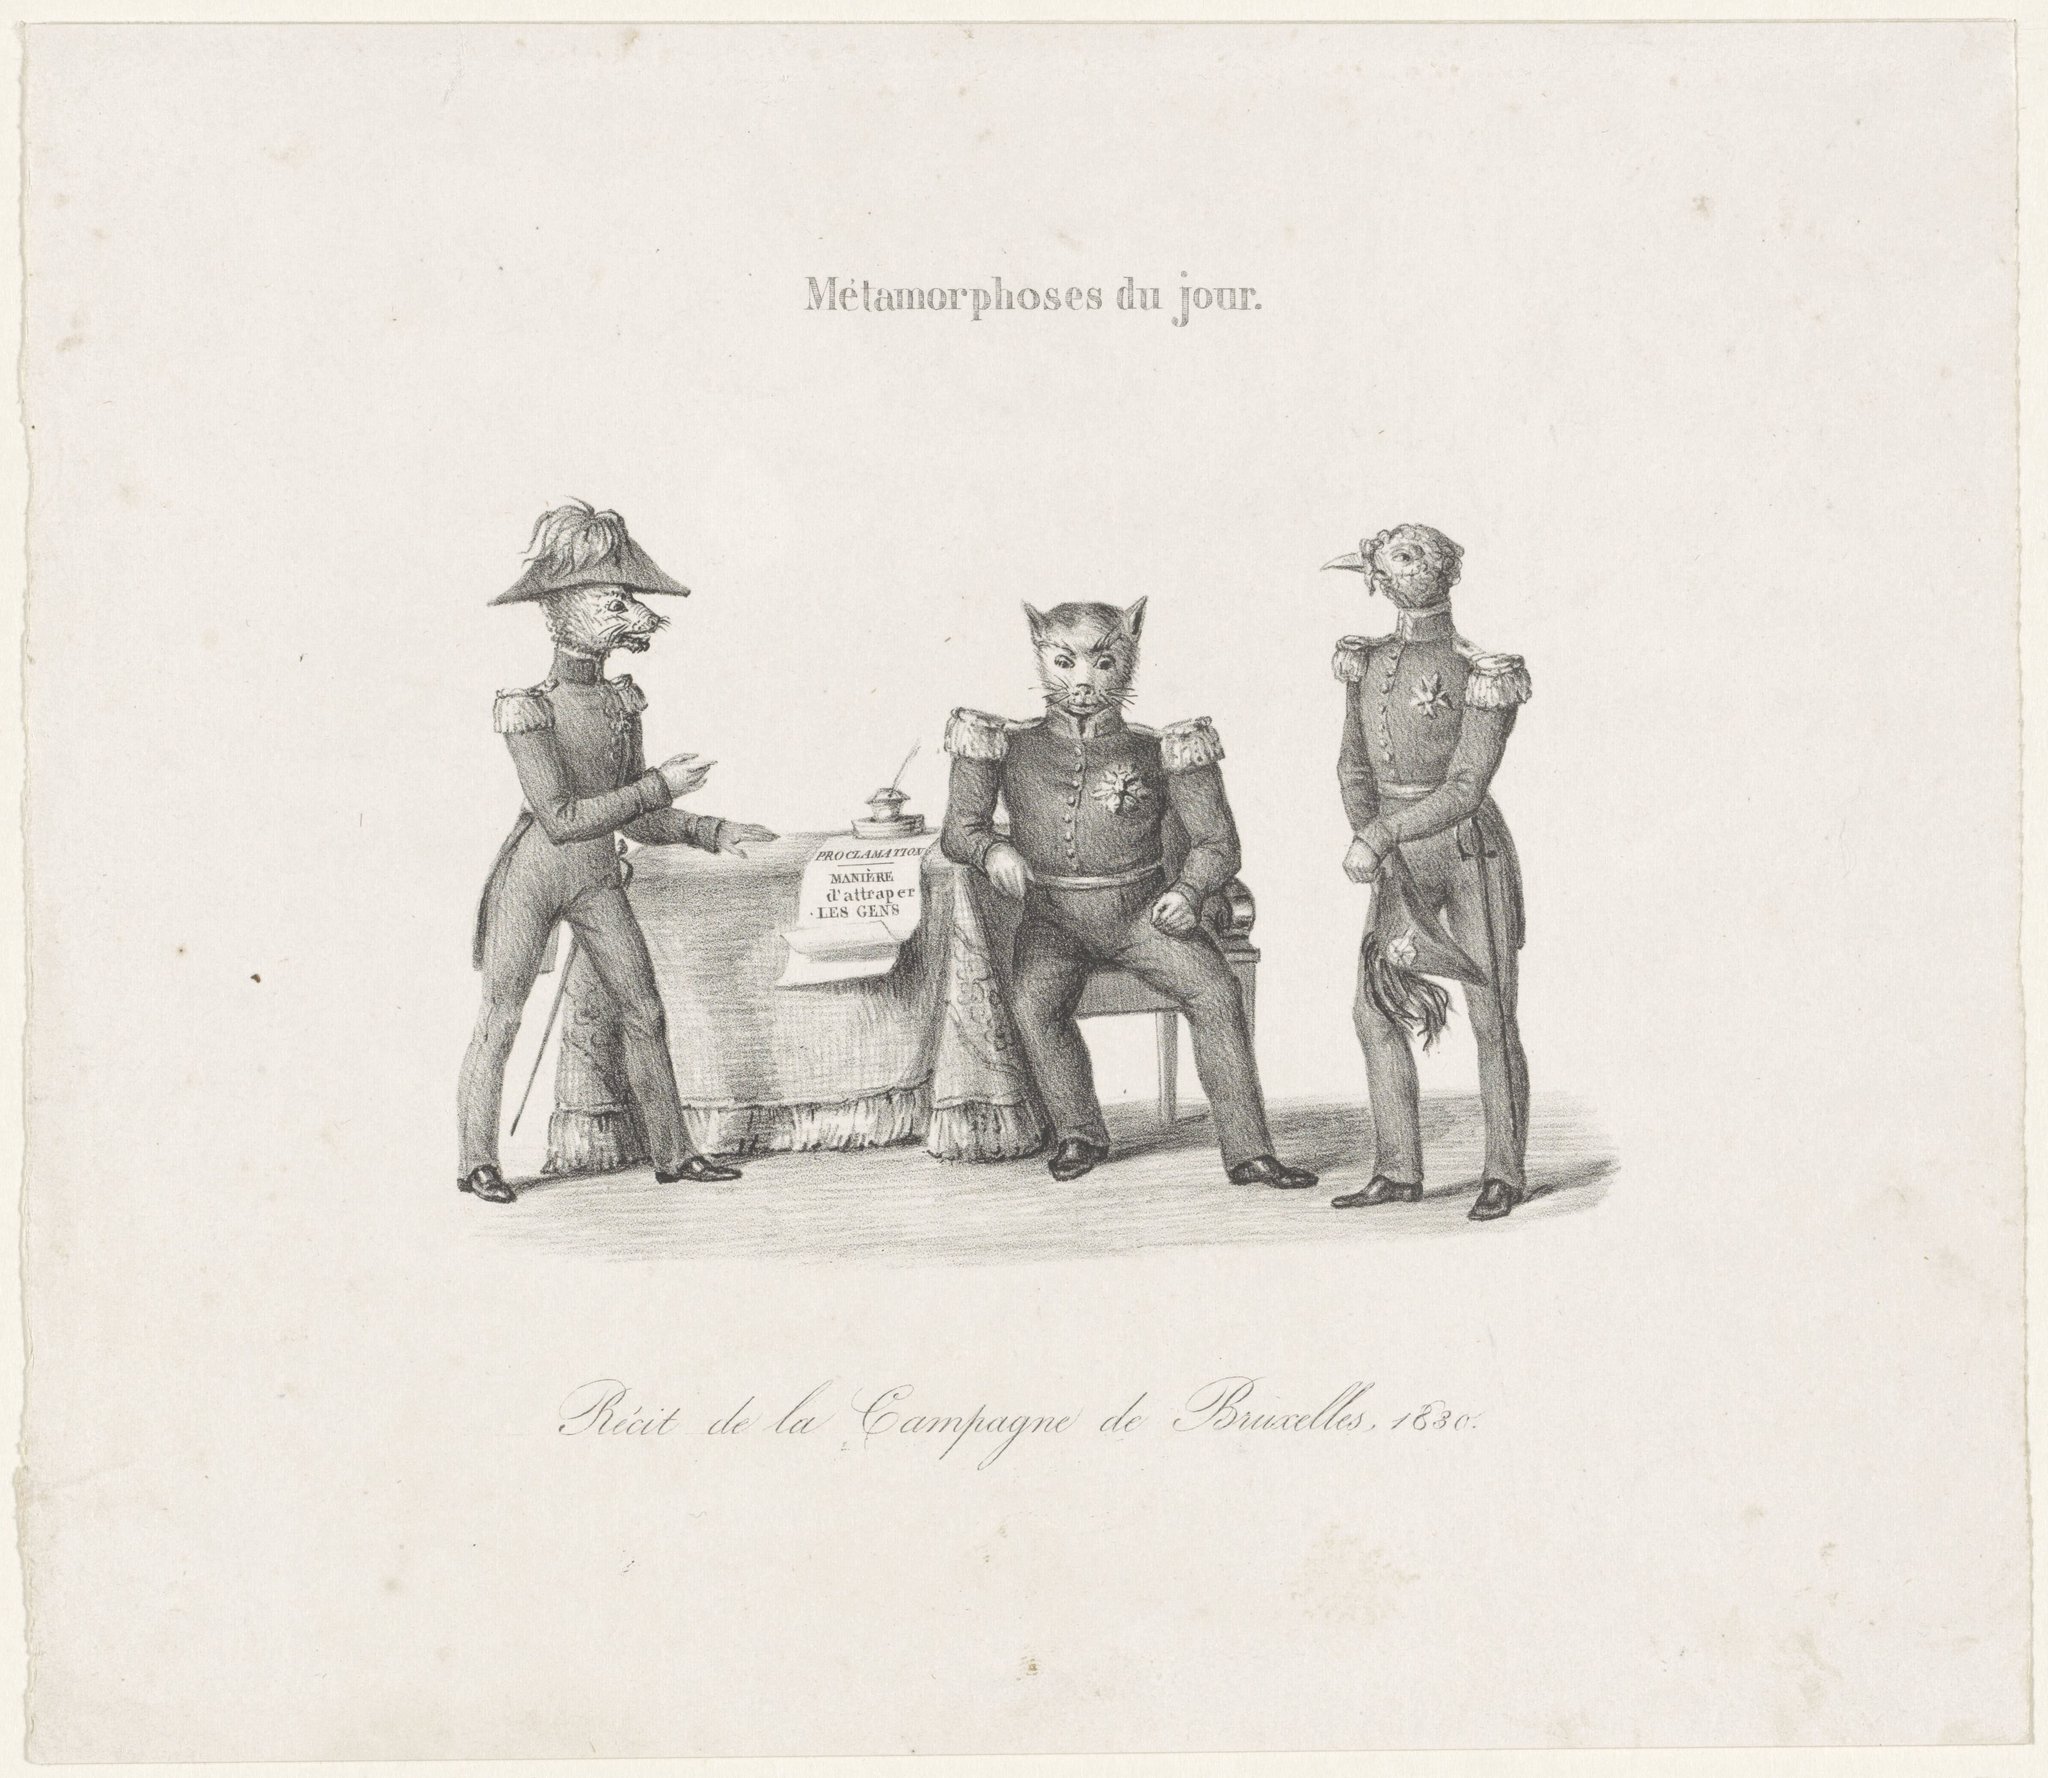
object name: cartoon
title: Krijgsberaad na Brusselse veldtocht, 1830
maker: Anonymous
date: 1830-1831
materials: paper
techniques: lithograph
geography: belgium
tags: the hague, berlin, william i of the netherlands, frederik (prins der nederlanden), animals acting as human beings, council of war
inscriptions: collector's mark: Lugt 2228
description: Spotprent op koning Willem I en prins Frederik na de mislukking van de Brusselse veldtocht, 1830. Prins Frederik (links) als een kat spreekt zijn vader toe. Koning Willem I zit als een kat aan een tafel, rechts een hoge militair (generaal Trip?) als een kalkoen. Op tafel ligt de proclamatie 'Manière d'attraper Les Gens'.